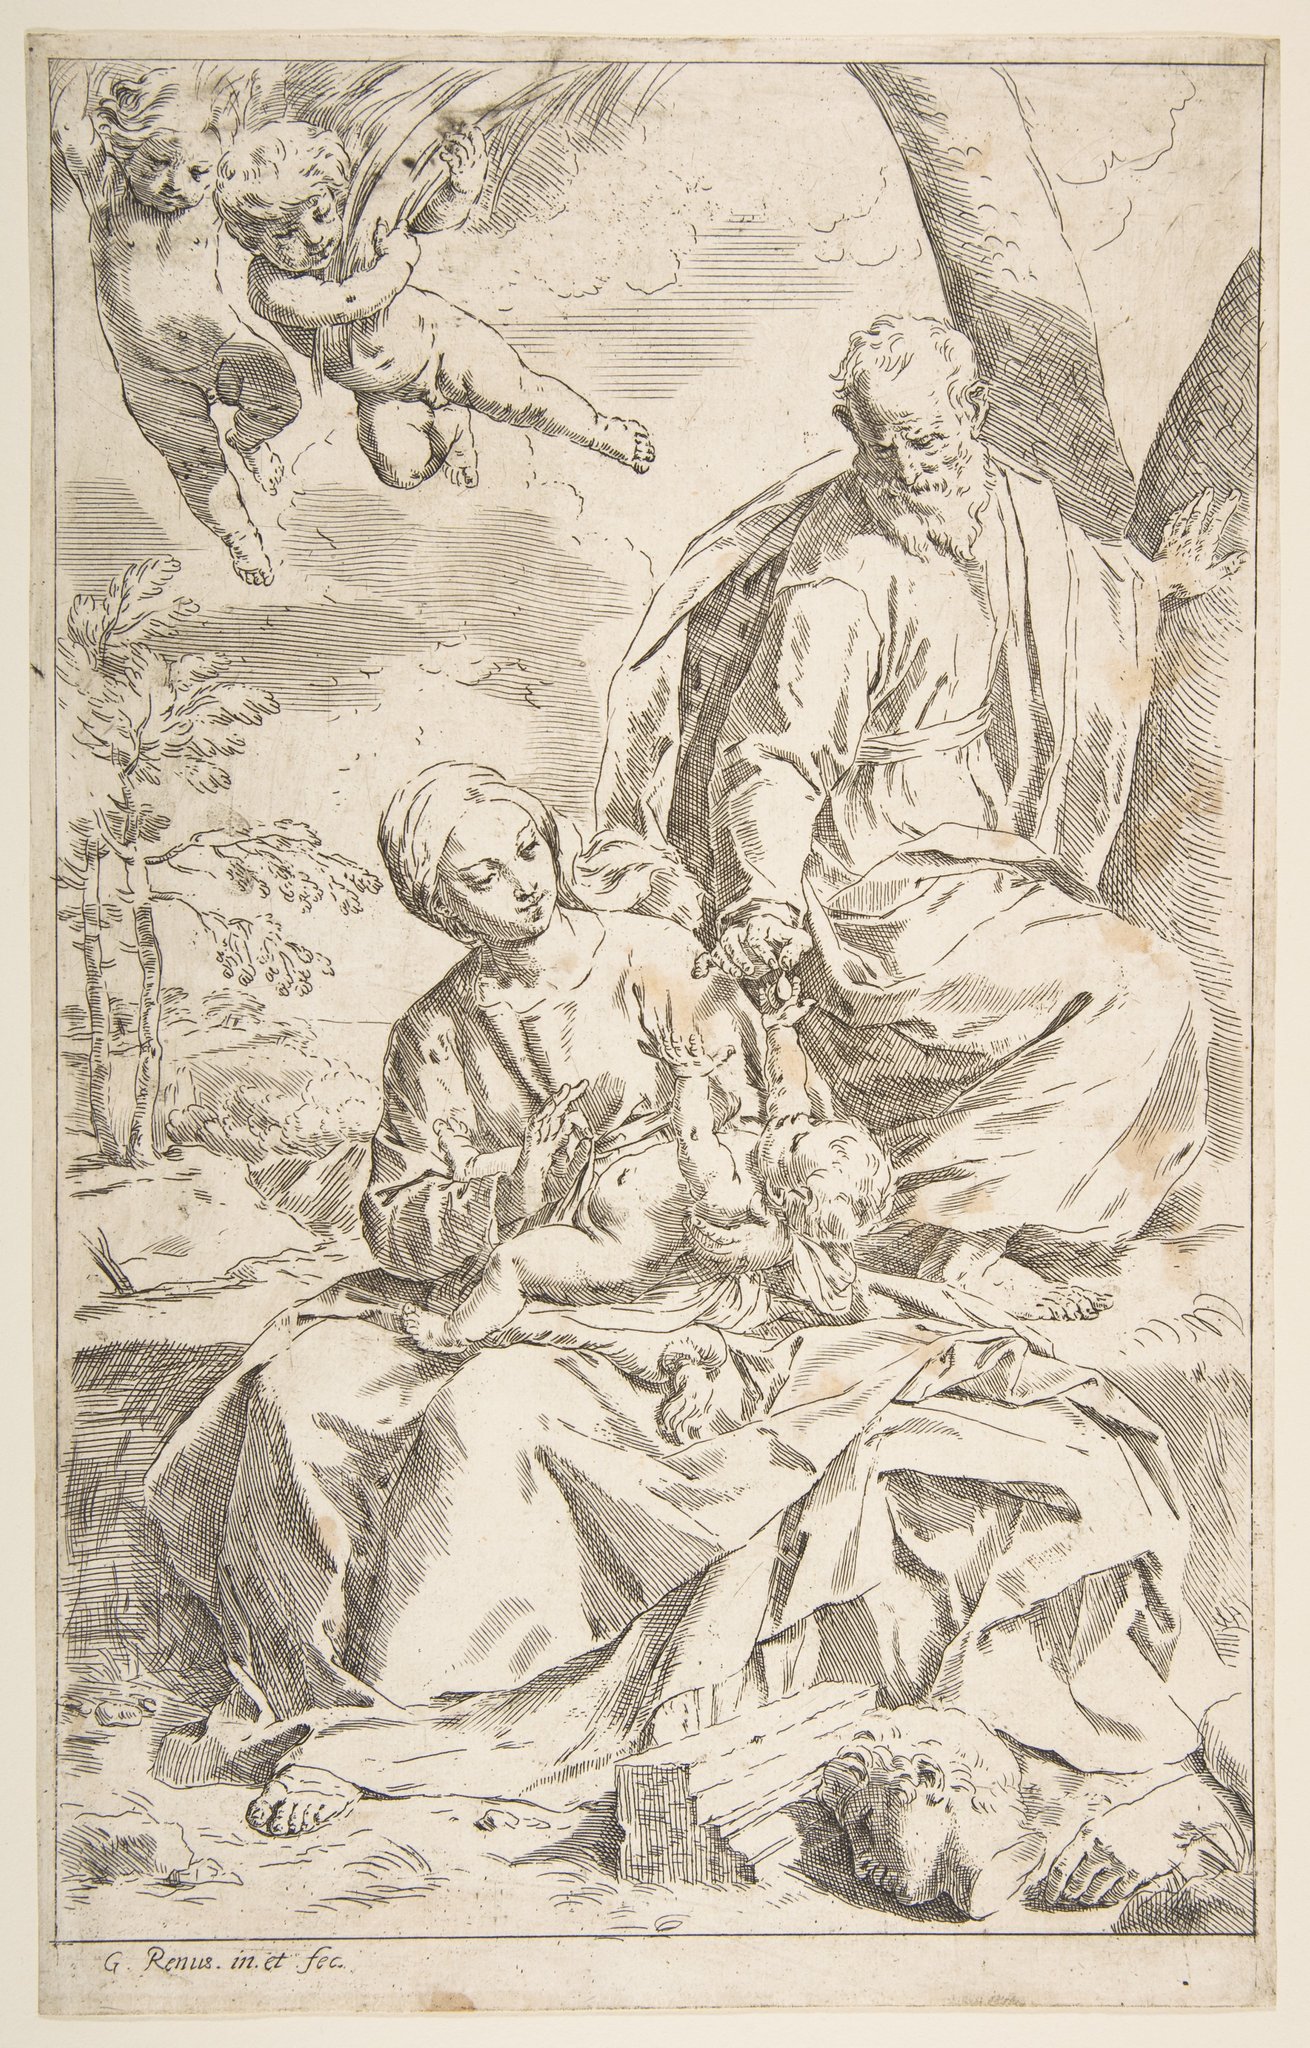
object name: print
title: Rest on the flight into Egypt, Mary holding the infant Christ while St. Joseph hands him a fruit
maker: simone cantarini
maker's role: artist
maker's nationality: italian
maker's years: 1612-1648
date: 1639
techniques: etching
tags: christ,virgin mary